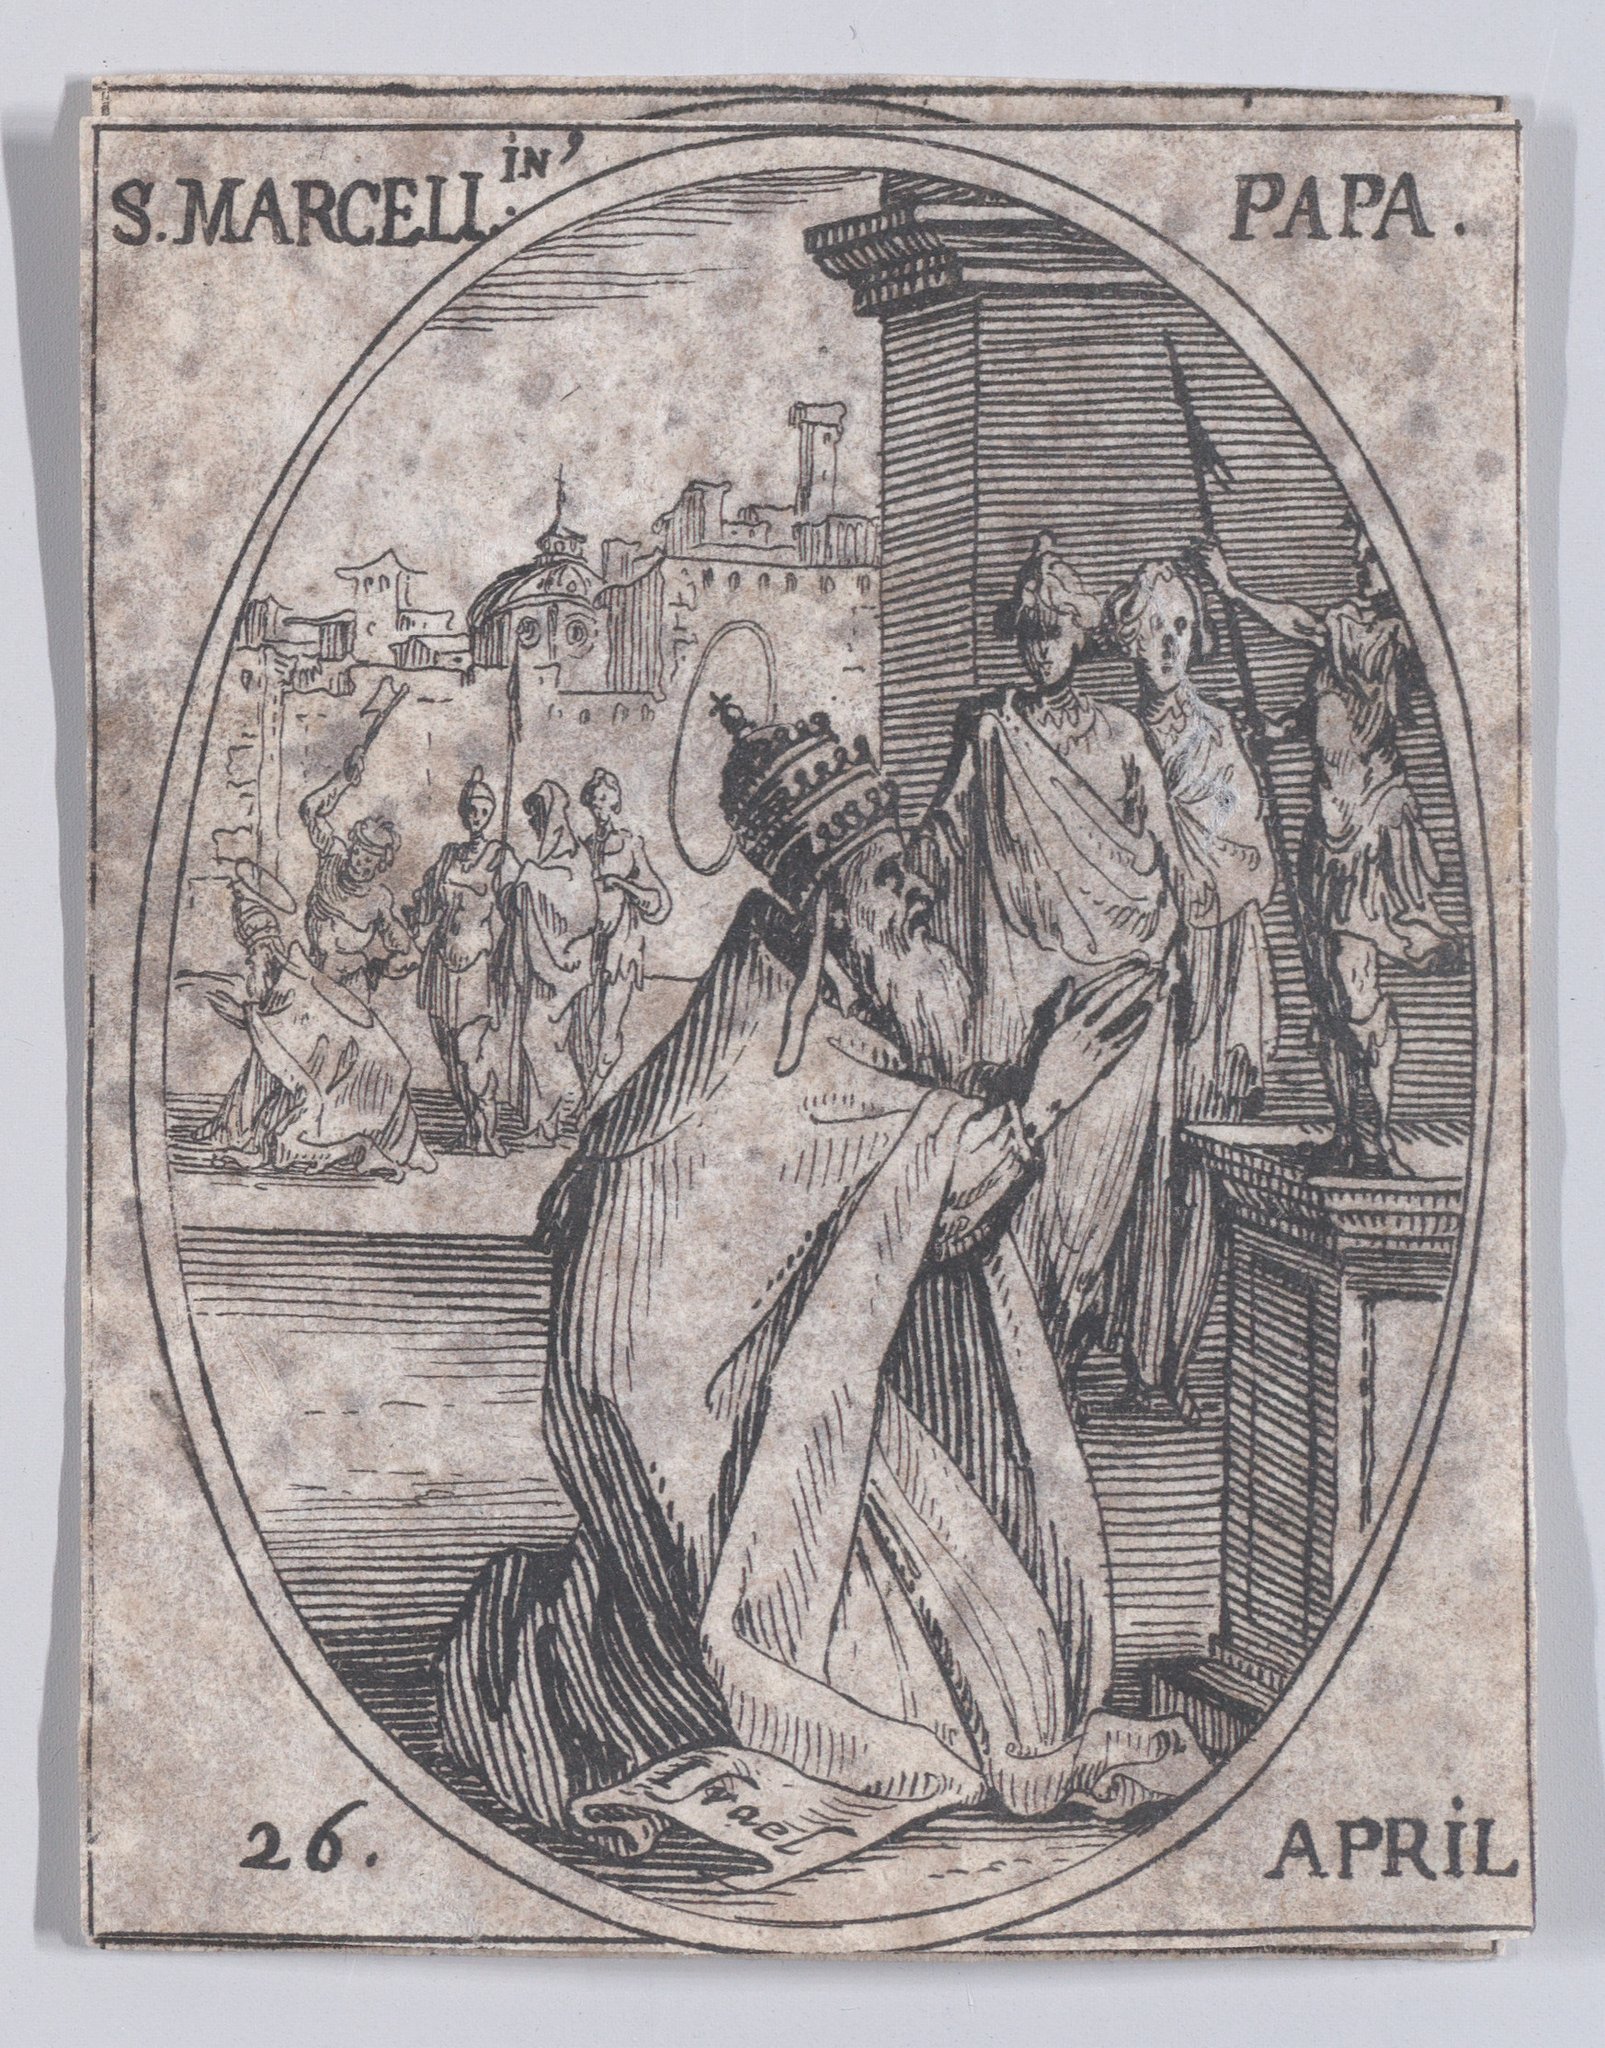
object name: print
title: S. Marcellin, pape (St. Marcellinus, Pope), April 26th, from "Les Images De Tous Les Saincts et Saintes de L'Année" (Images of All of the Saints and Religious Events of the Year)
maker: jacques callot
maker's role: artist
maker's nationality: french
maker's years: 1592-1635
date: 1636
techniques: etching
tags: men,saints